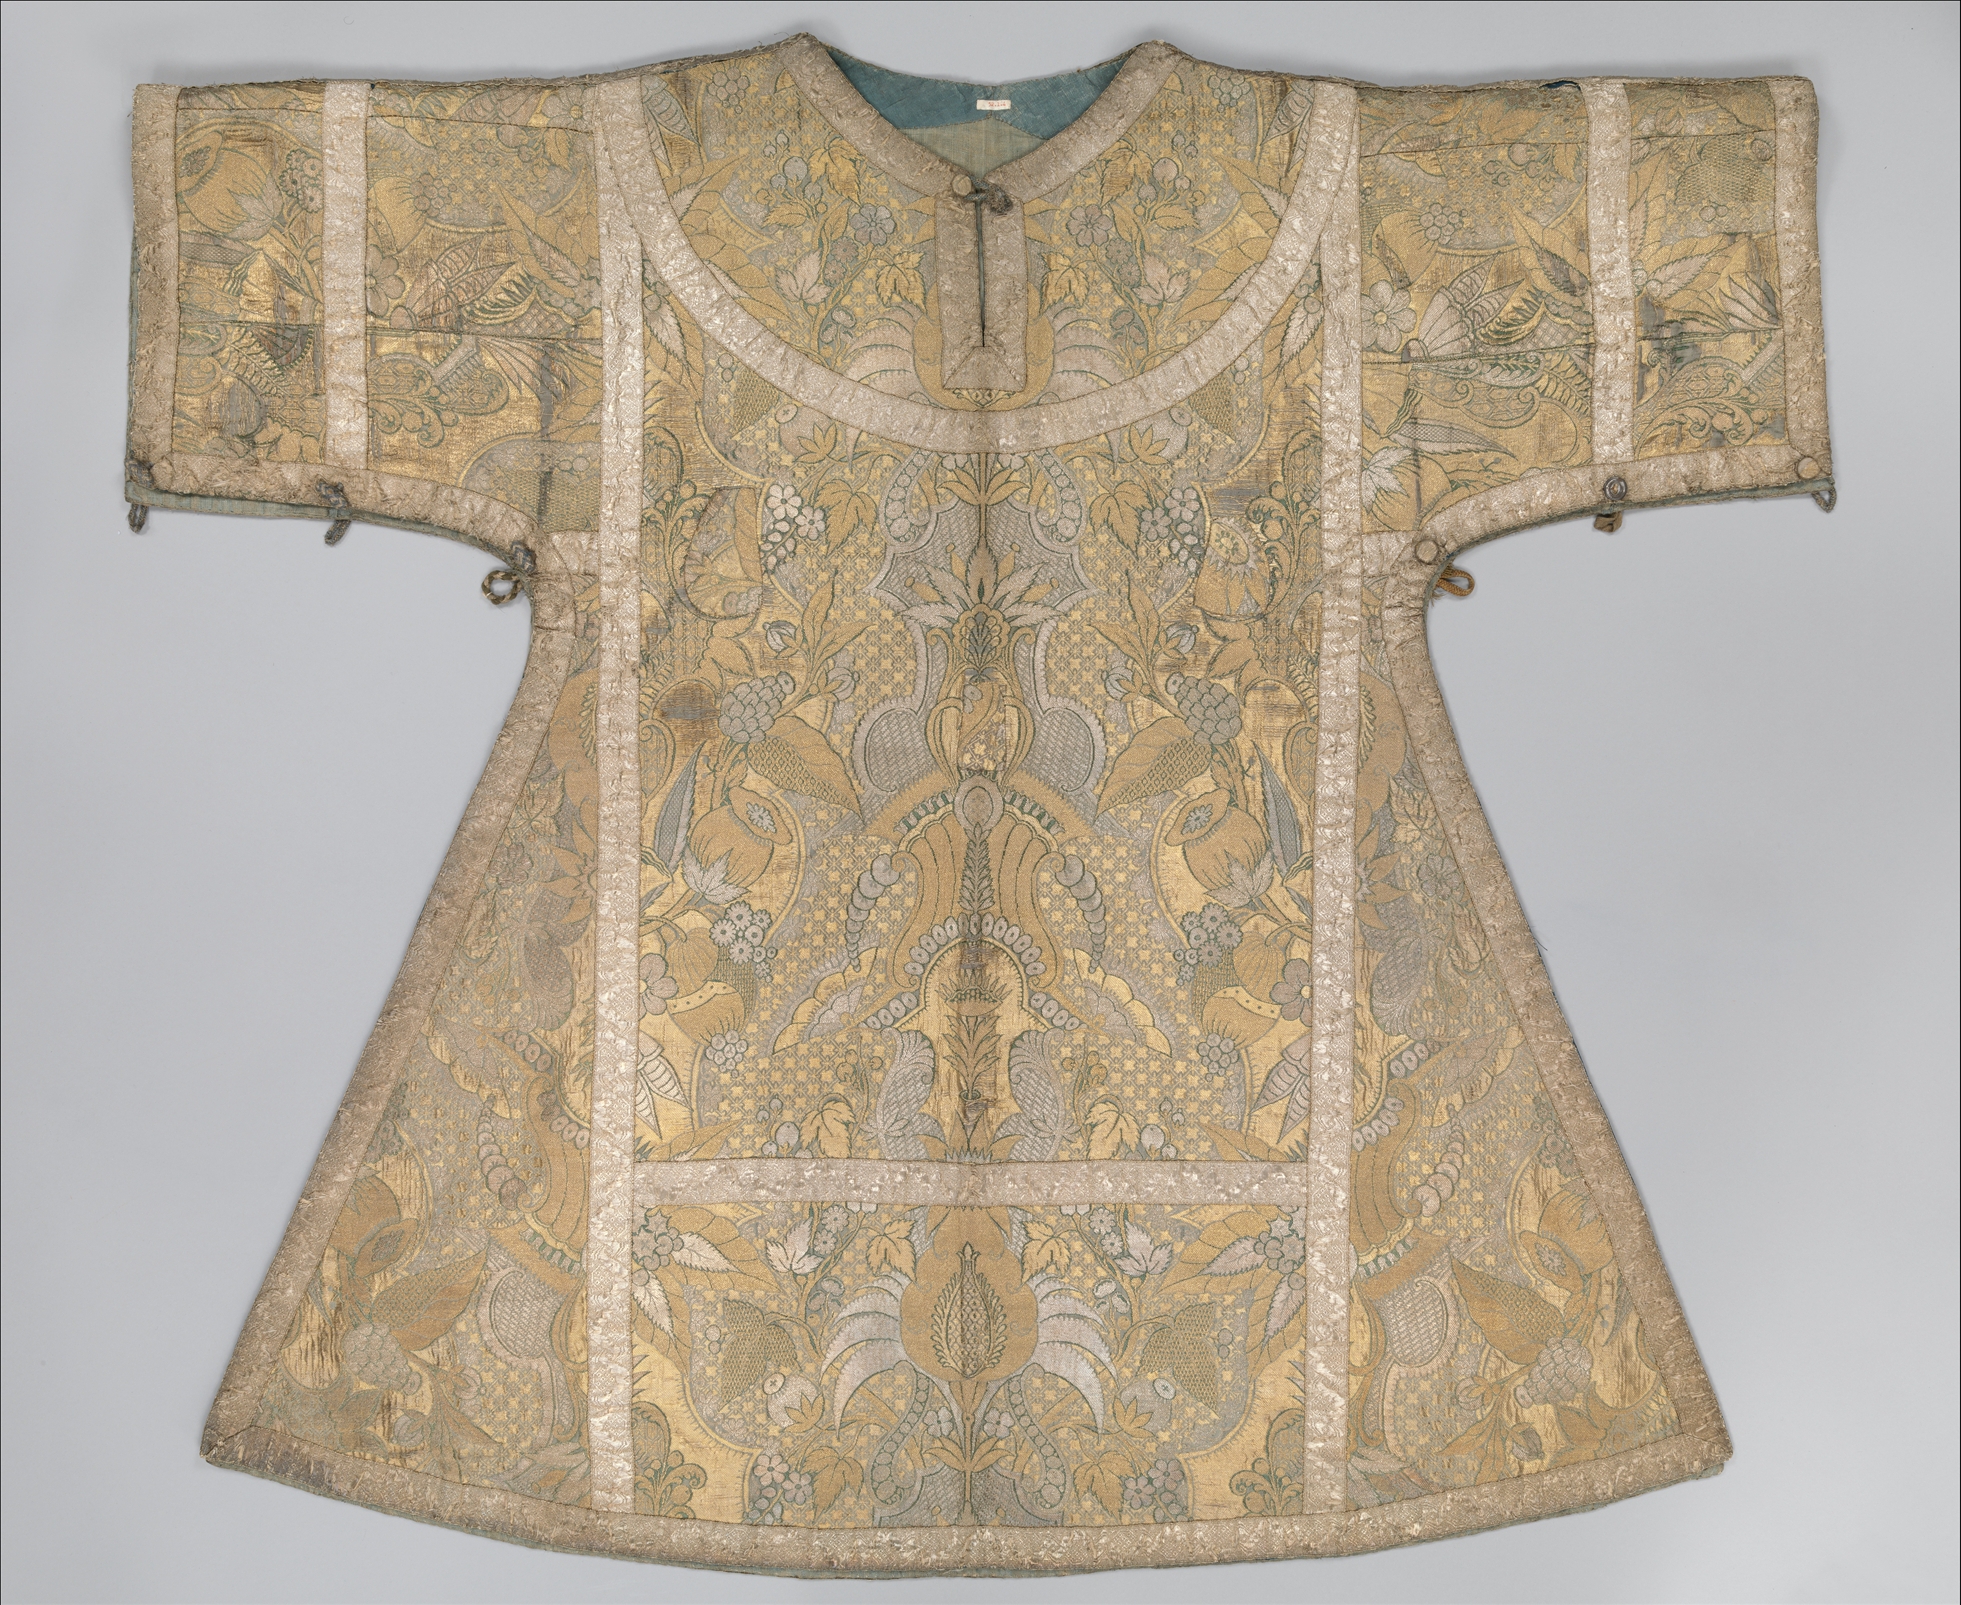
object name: dalmatic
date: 1720-1725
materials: metal thread, silk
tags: flowers,leaves